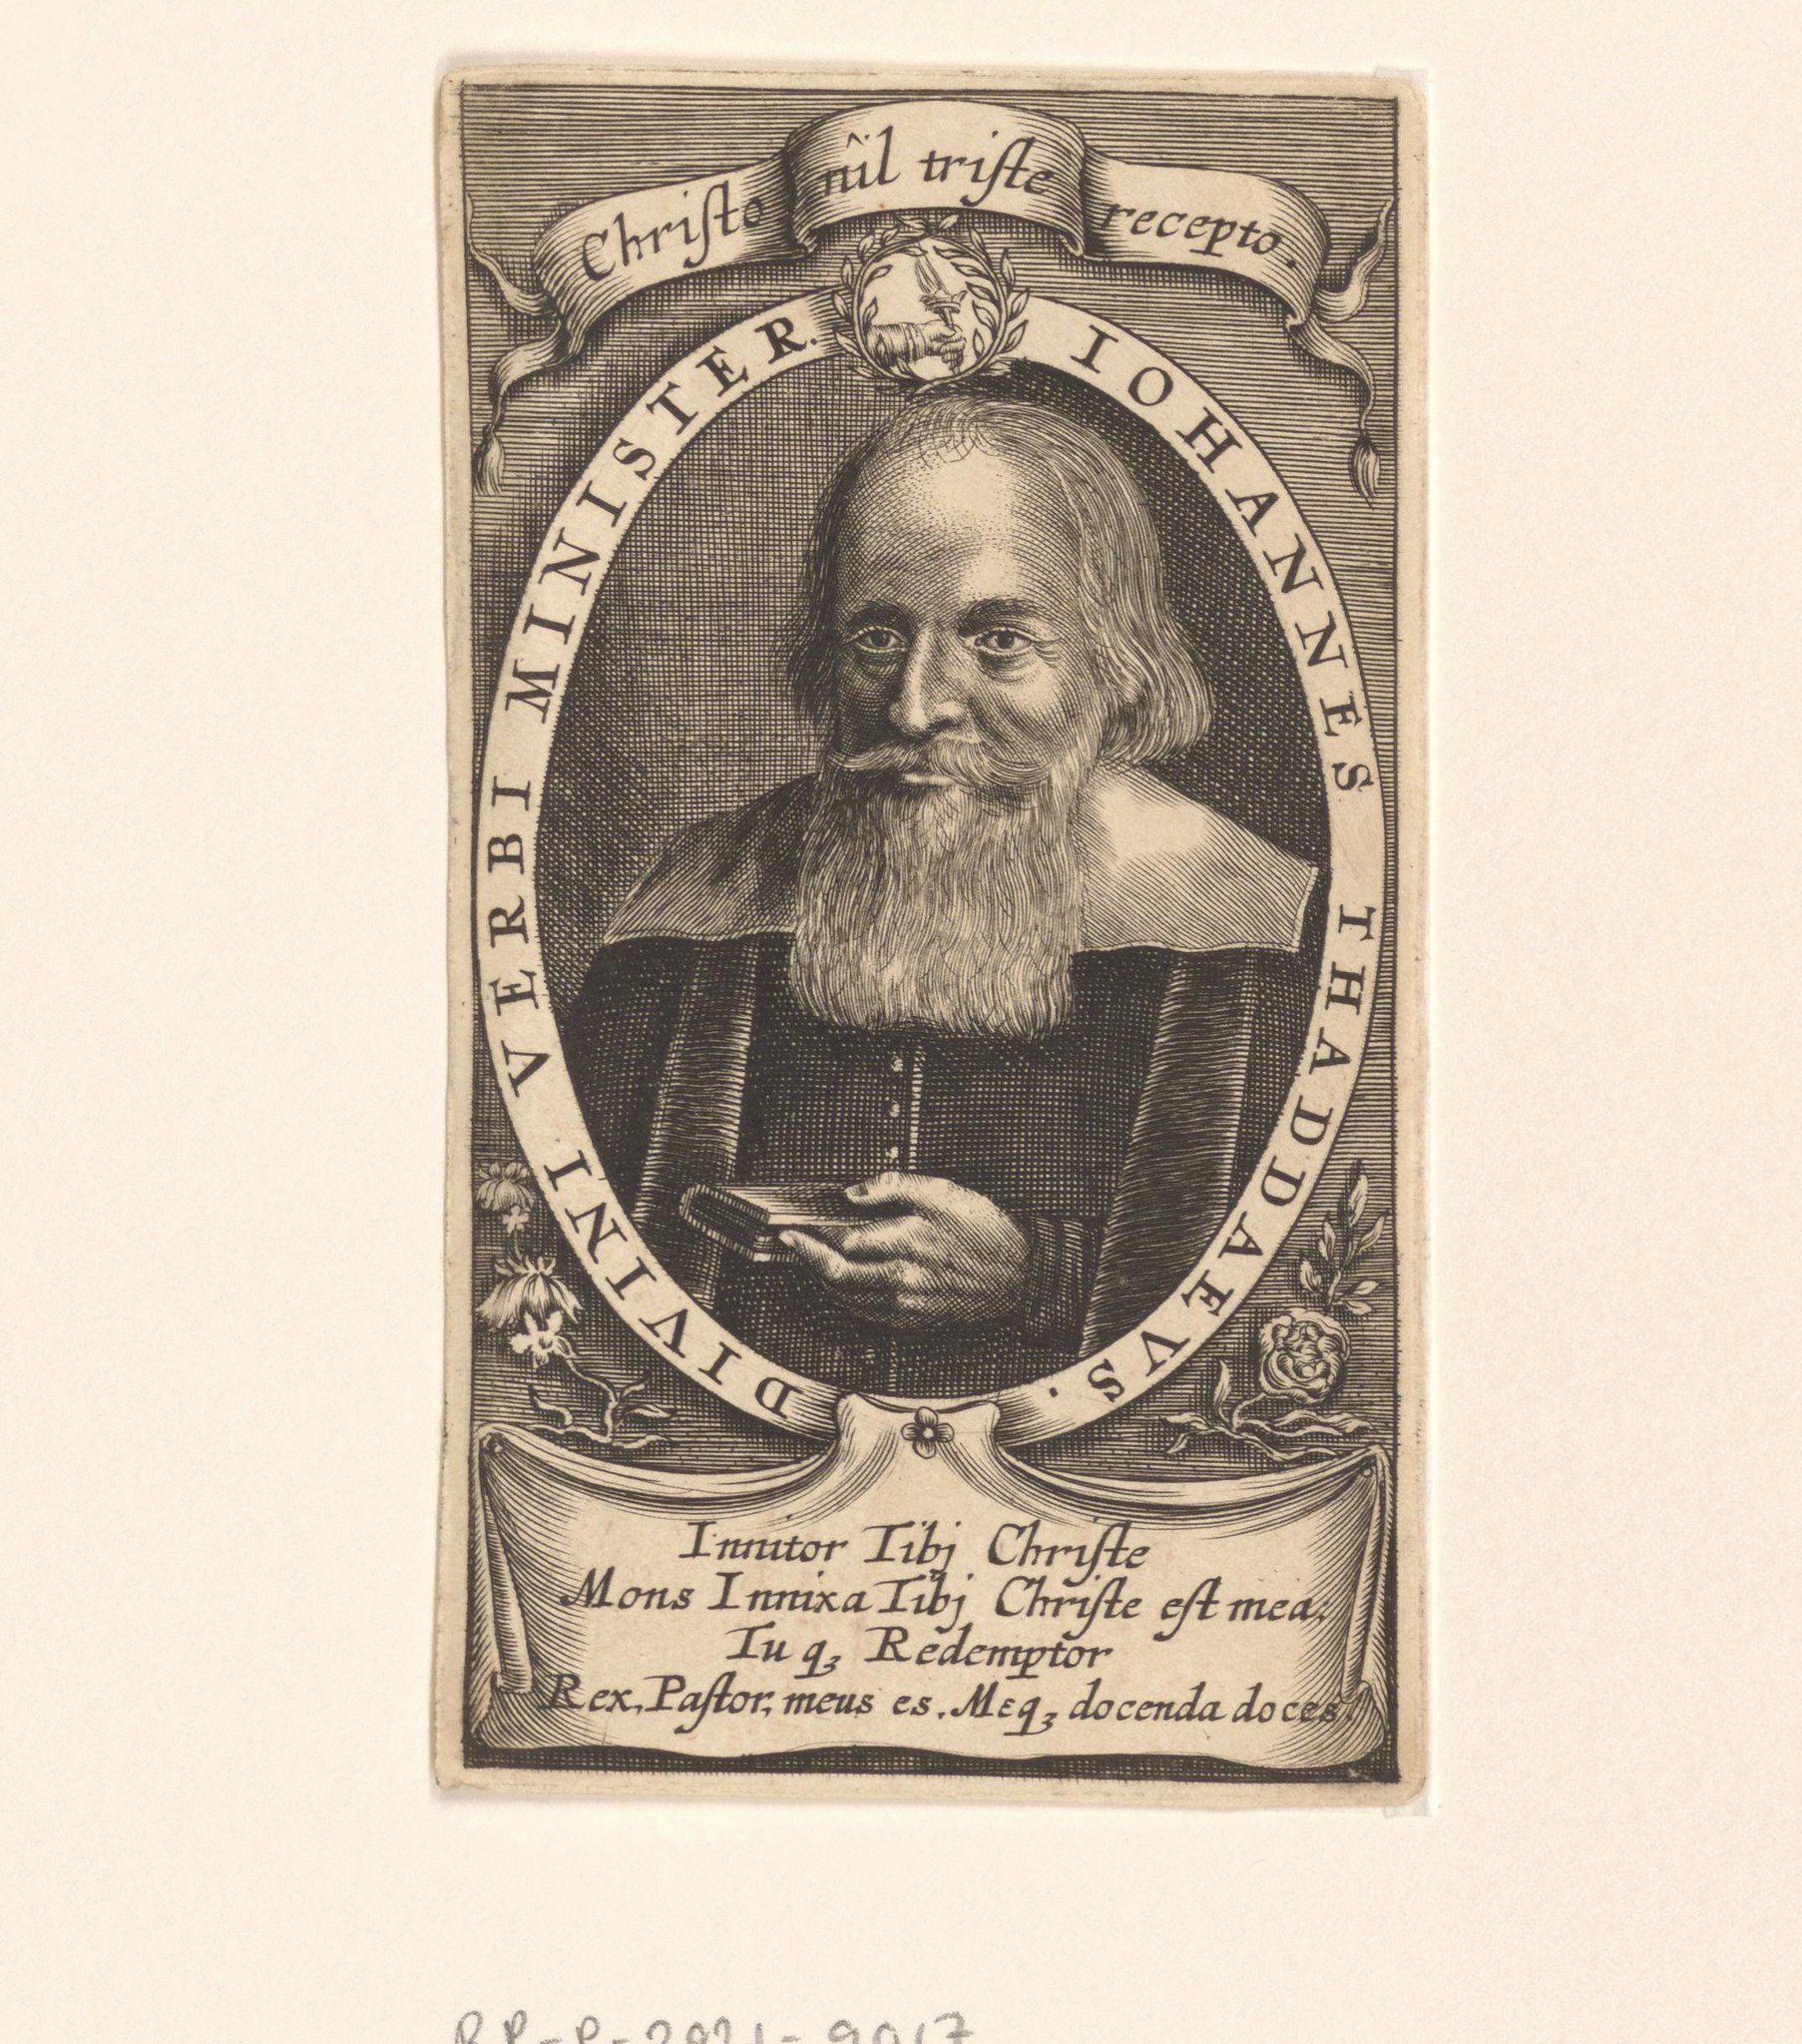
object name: book illustration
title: Portret van Johannes Thaddaeus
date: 1648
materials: paper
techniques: engraving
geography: amsterdam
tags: historical persons, functionaries and dignitaries ~ episcopal protestant churches, book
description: Prent uit: Thaddaeus, Johannes. Conciljatorium biblicum. Amsterdam: Johannes Janssonius, 1648.